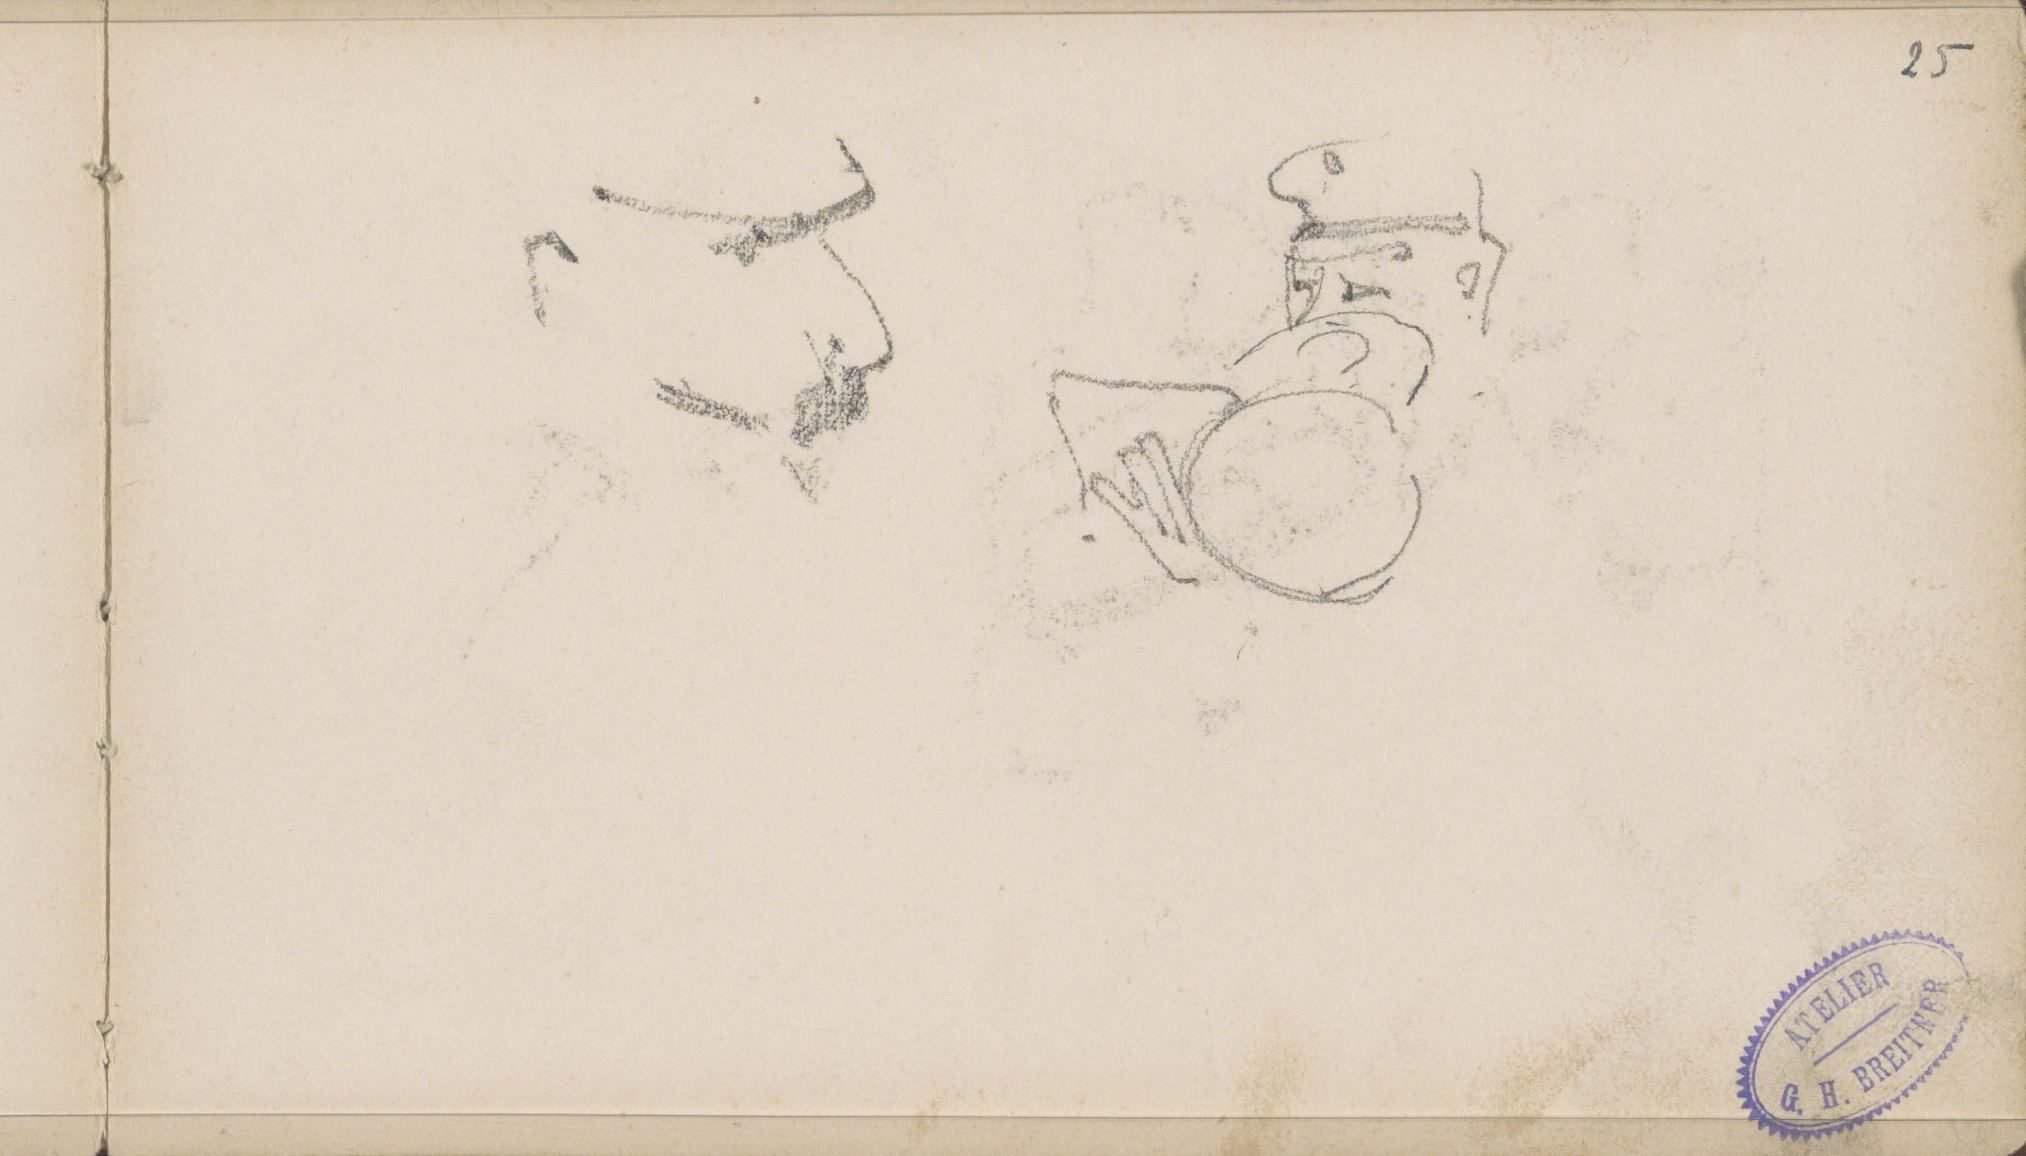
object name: sketchbook leaf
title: Twee mannenhoofden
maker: george hendrik breitner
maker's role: draughtsman, painter, print maker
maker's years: 1857-1923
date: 1880-1882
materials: paper, pencil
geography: the hague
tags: head (human)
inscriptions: workshop stamp: Lugt 291d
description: Blad 25 recto uit een schetsboek met 16 bladen.